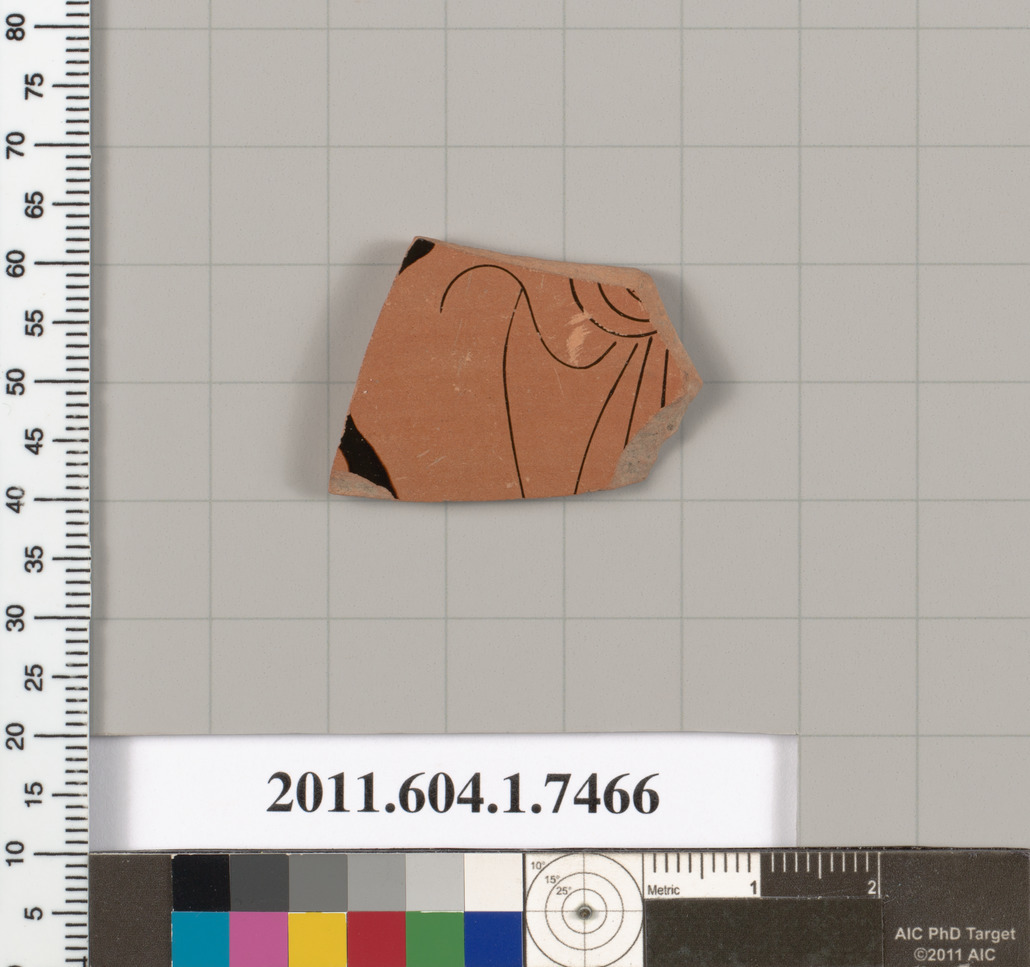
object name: kylix fragment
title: Terracotta fragment of a kylix (drinking cup)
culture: greek, attic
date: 470-460 BCE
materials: terracotta